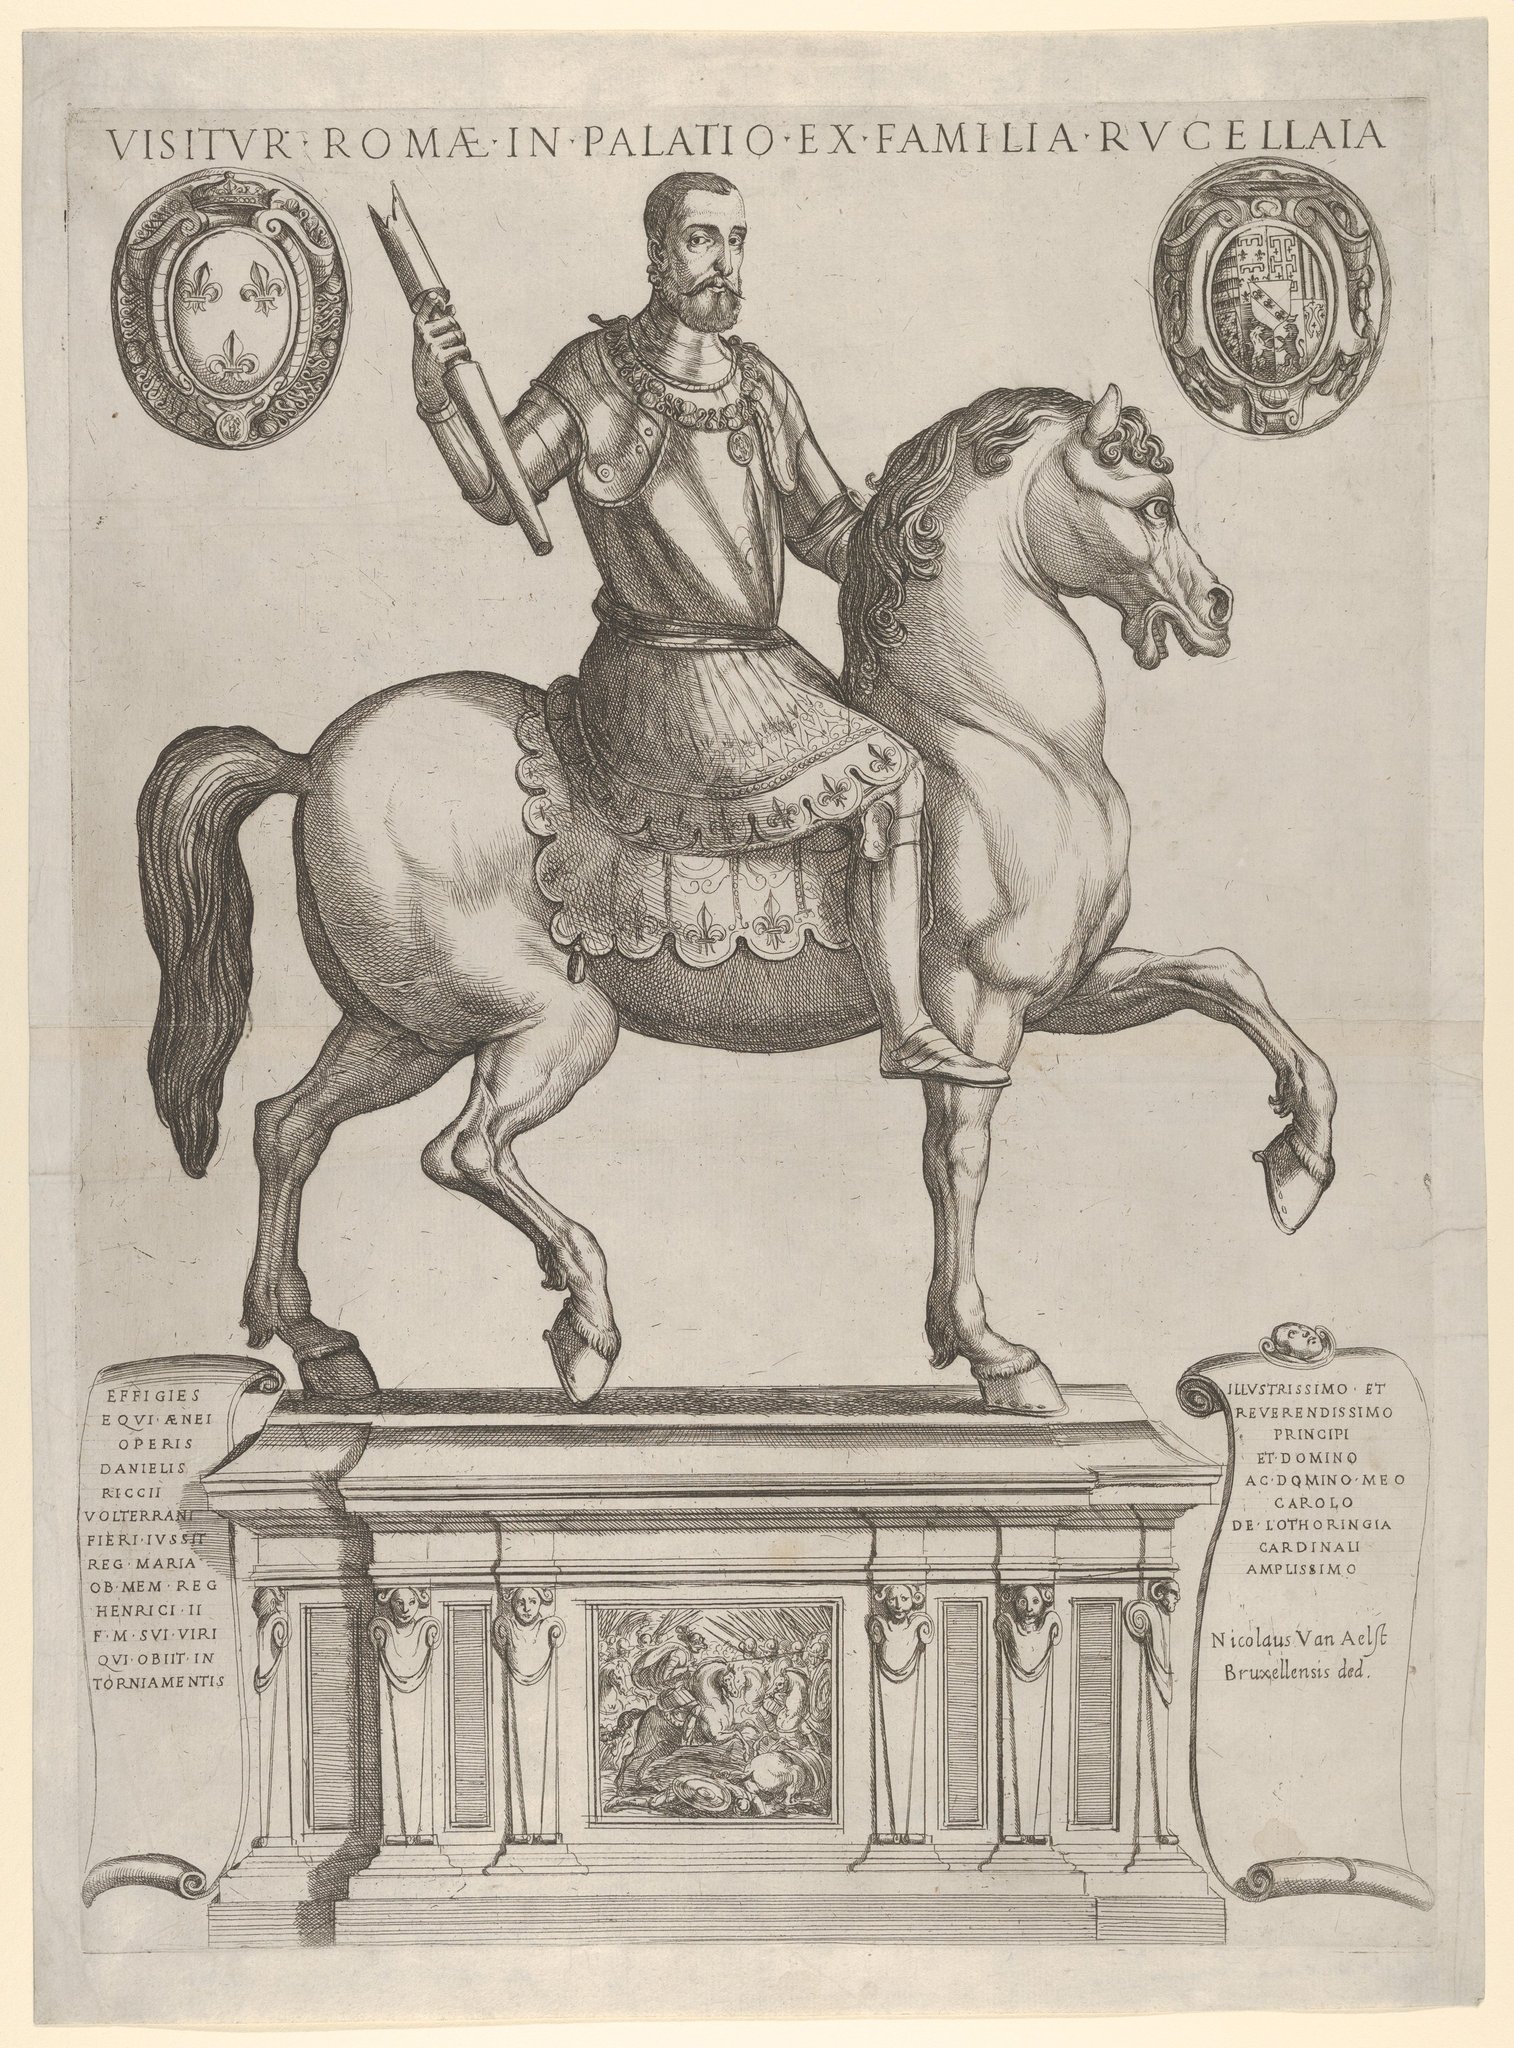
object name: print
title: Equestrian Statue of Henry II, King of France, in the Palazzo Rucellai by Daniele de Volterra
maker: antonio tempesta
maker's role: artist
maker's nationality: italian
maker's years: 1555-1630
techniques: etching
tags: kings,horses